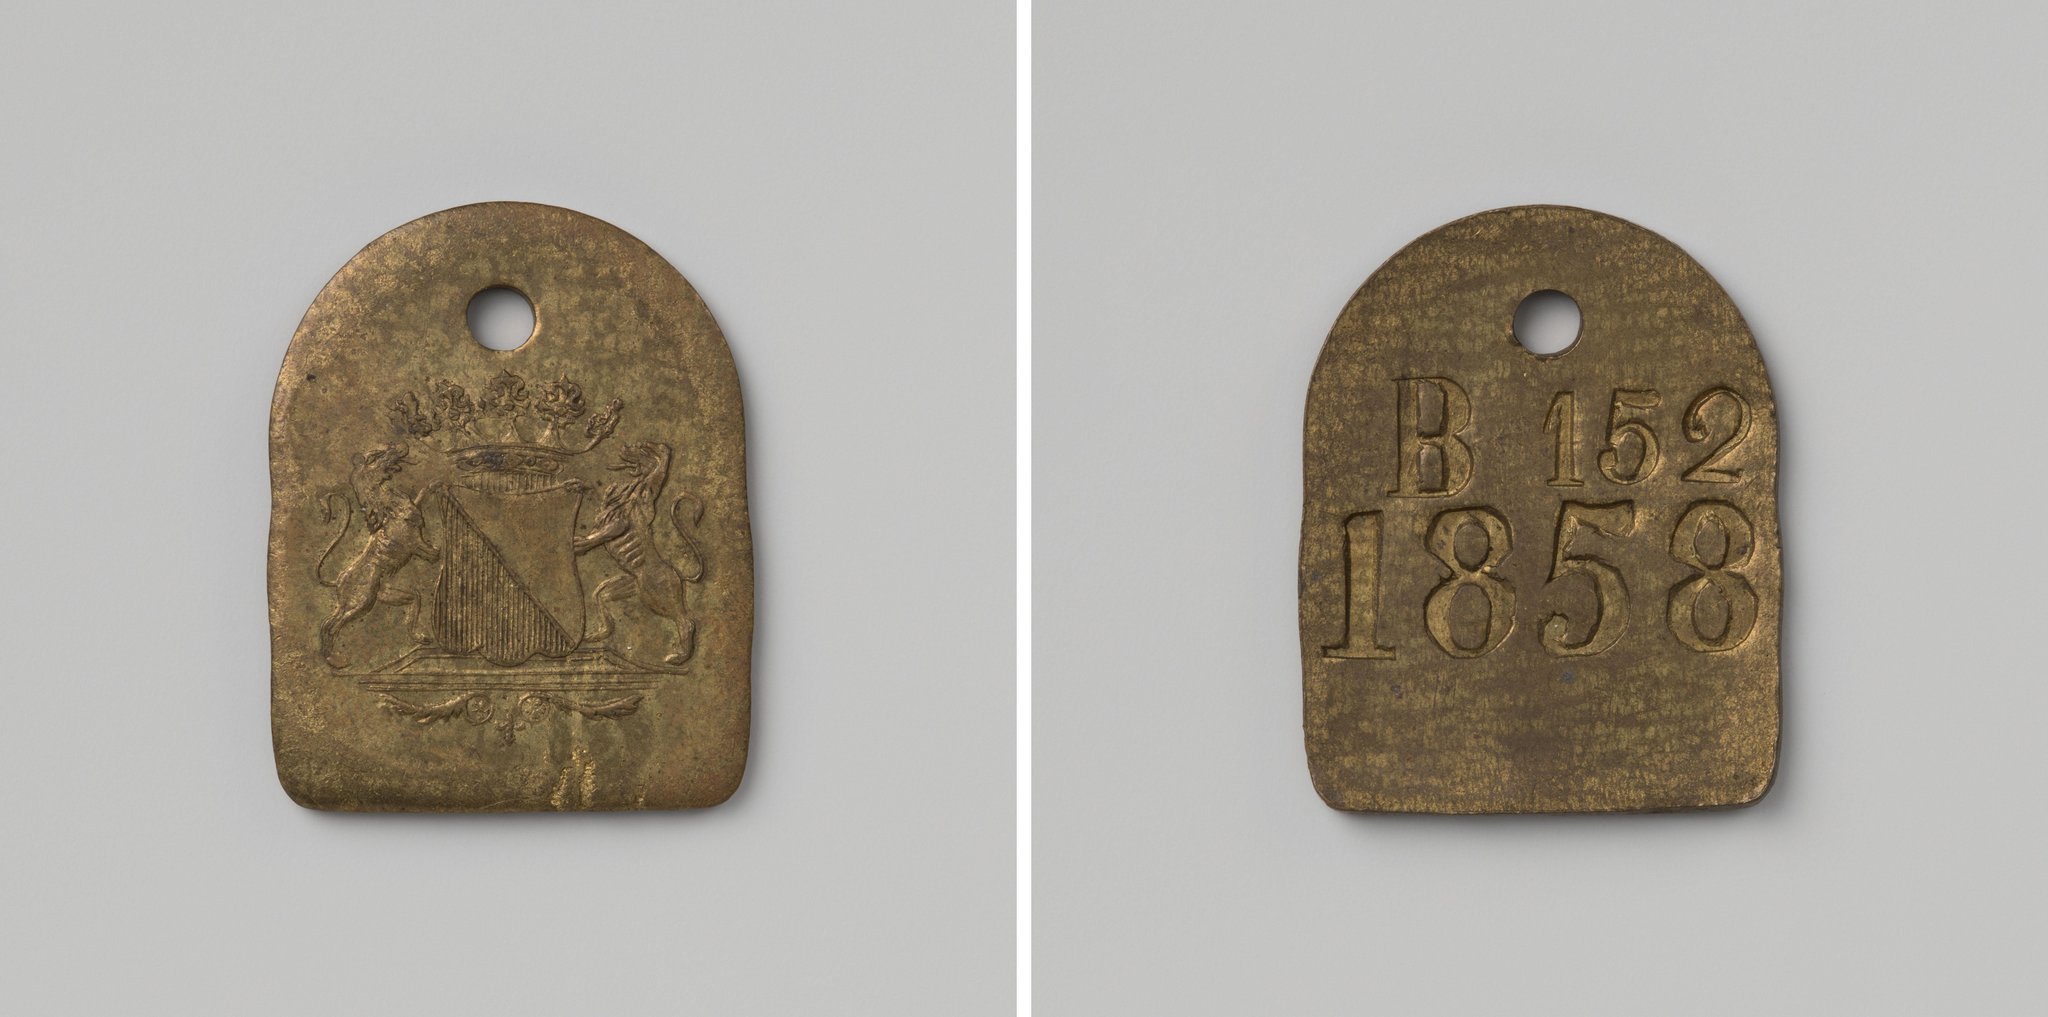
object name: tax token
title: Stad Utrecht, loodje met letter B en no. 152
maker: Anonymous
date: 1858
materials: brass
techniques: striking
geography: utrecht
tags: utrecht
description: rechthoekig loodje met aan bovenzijde ronde hoeken en gat erin. Voorzijde: letter B en cijfer 152 boven jaartal. Keerzijde: gekroond wapenschild, geflankeerd door twee leeuwen